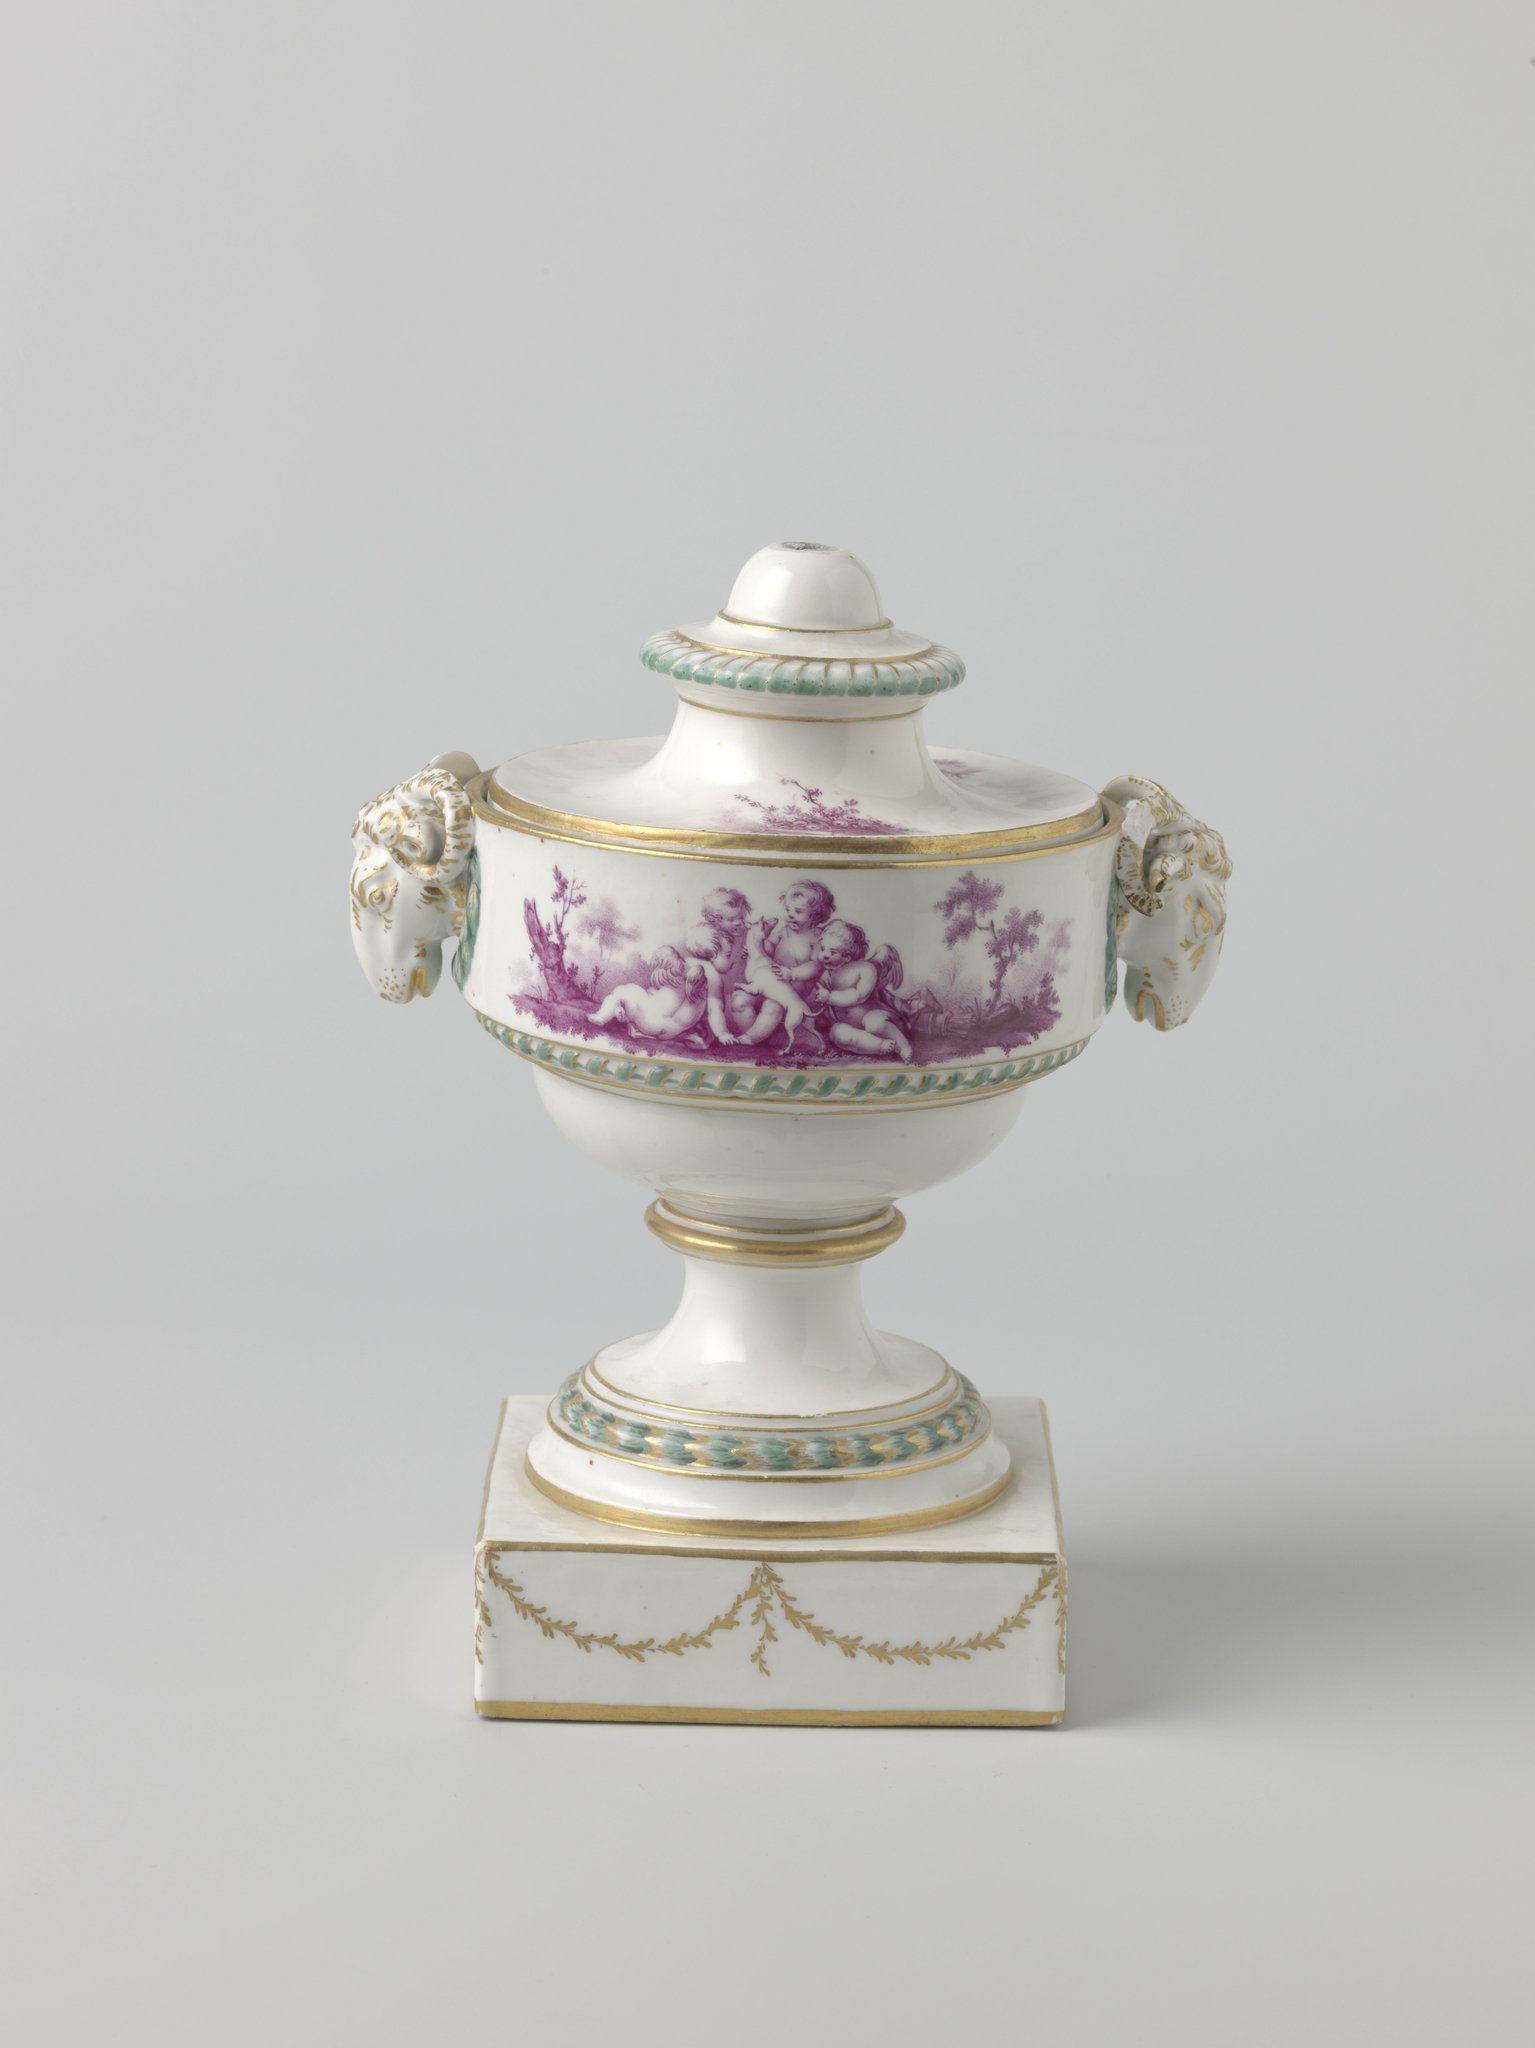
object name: vase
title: Vaas met deksel, beschilderd met putti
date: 1778-1782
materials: porcelain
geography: loosdrecht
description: Vase and cover. Porcelain. Loosdrecht, c. 1778 - 1782. Factory of Joannes de Mol.